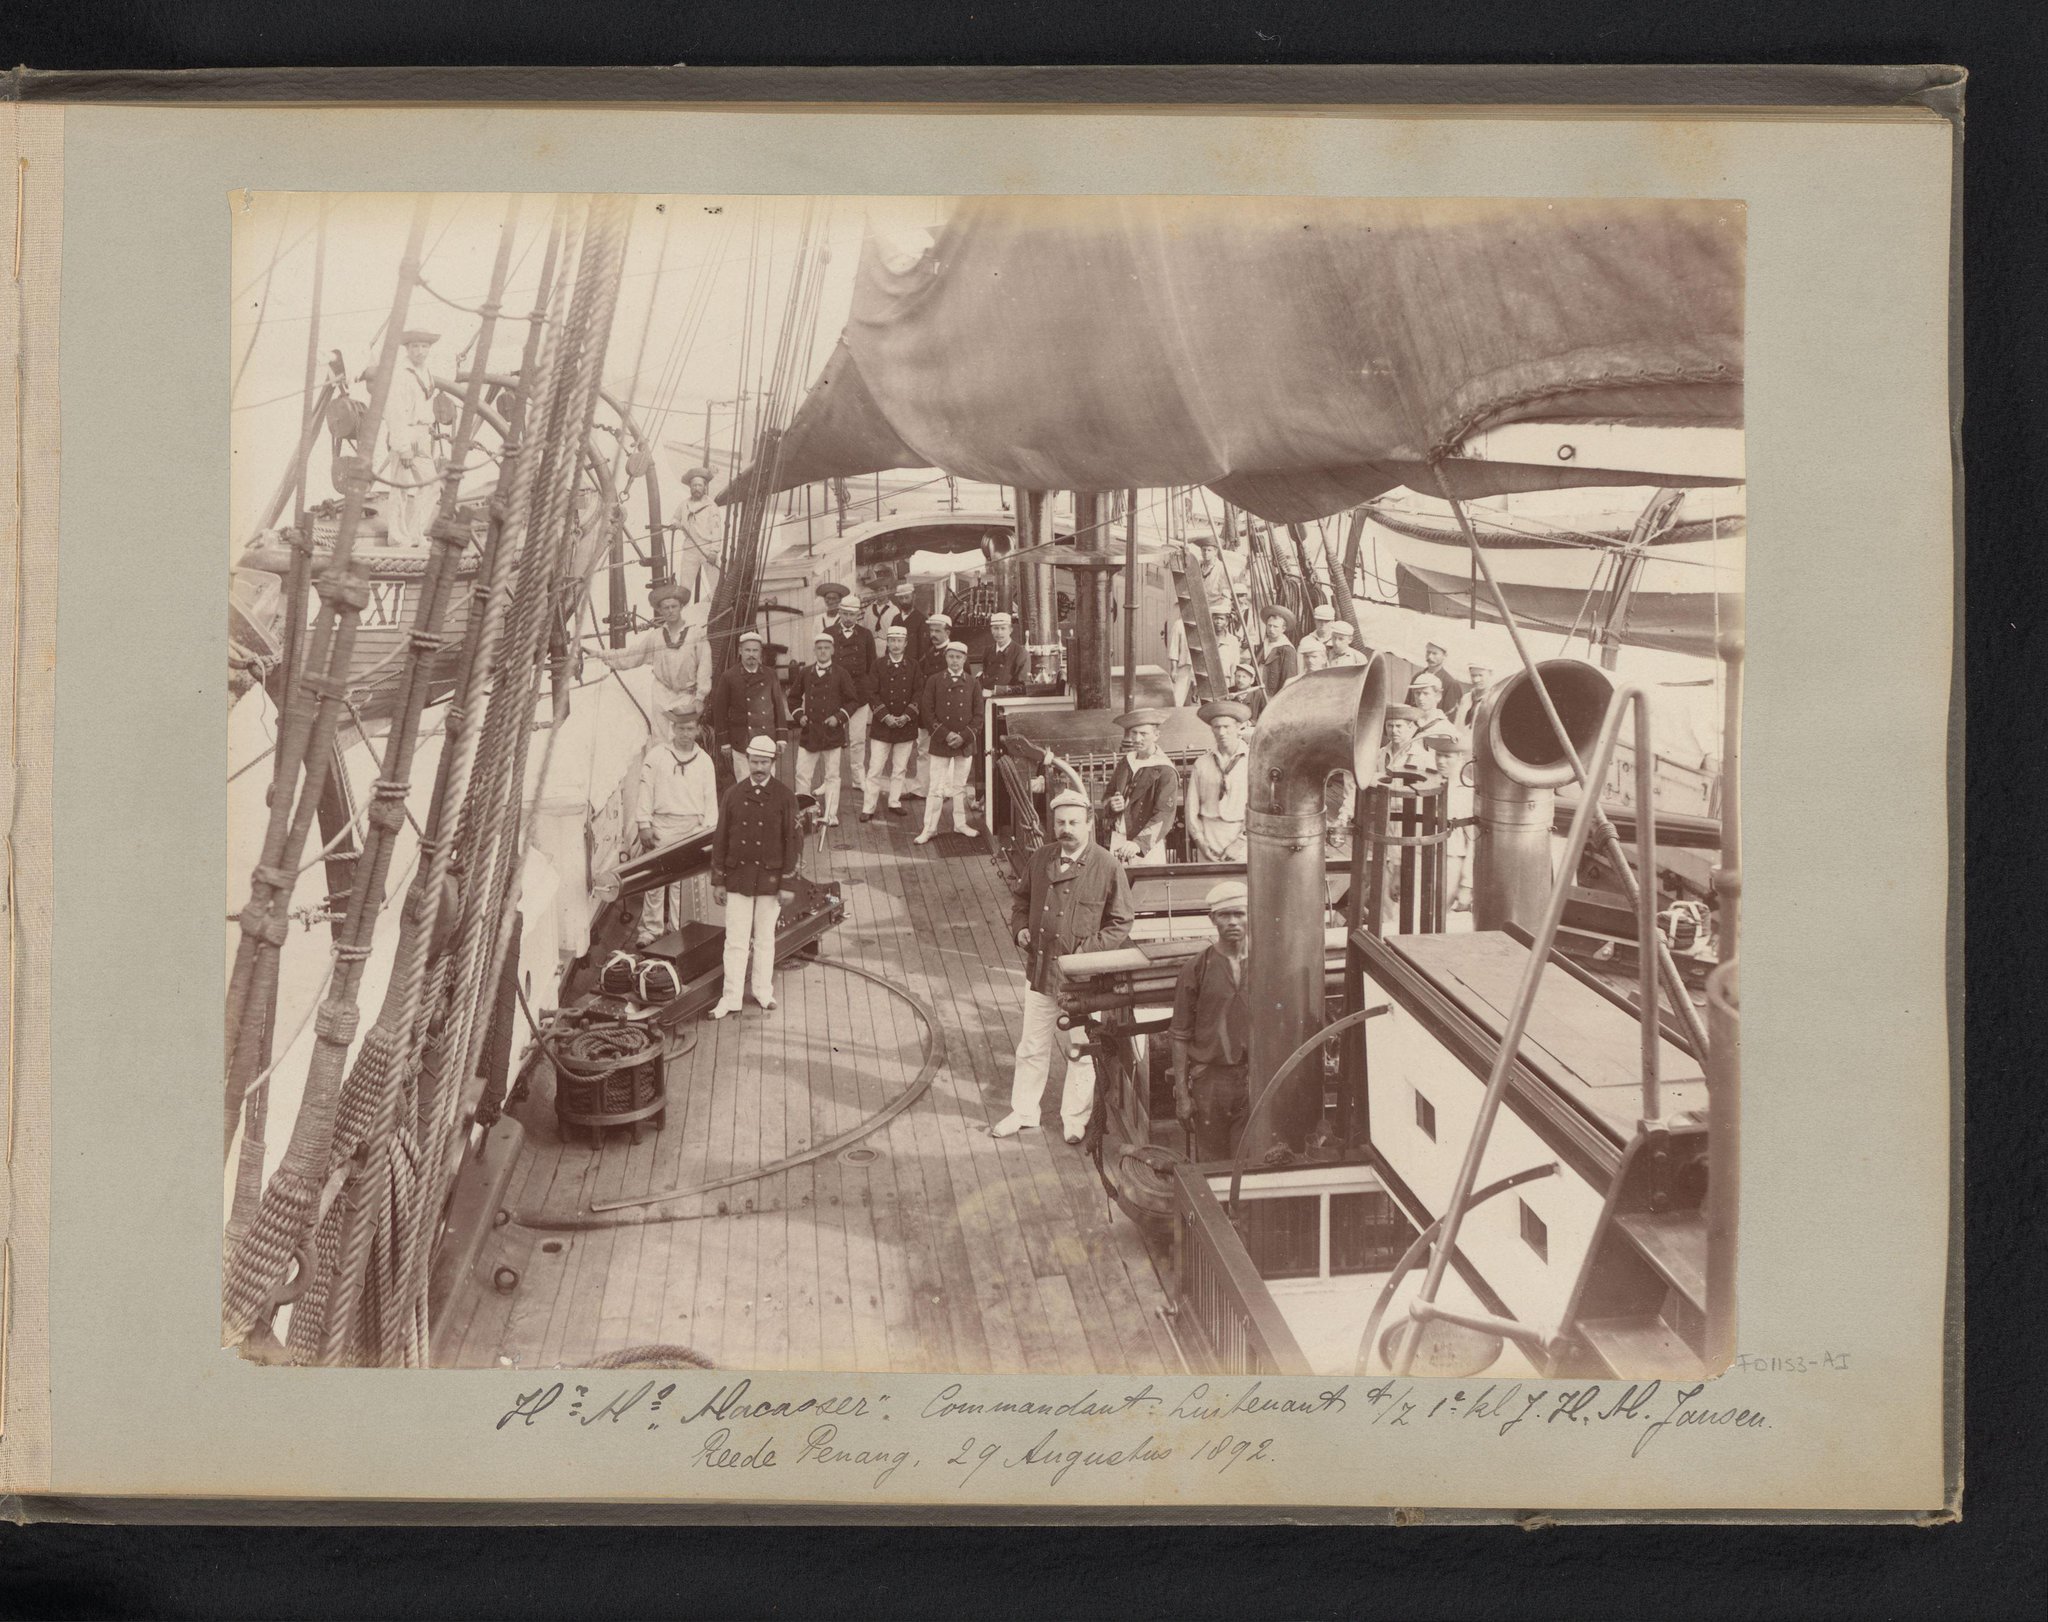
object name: photograph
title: Bemanning op zeilschip de Macasser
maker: Anonymous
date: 1892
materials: photographic support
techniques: albumen print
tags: europeans, warfare; military affairs (+ sailing-ships), sumatra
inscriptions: annotation: ‘Reede Penang, 29 Augustus 1892.’